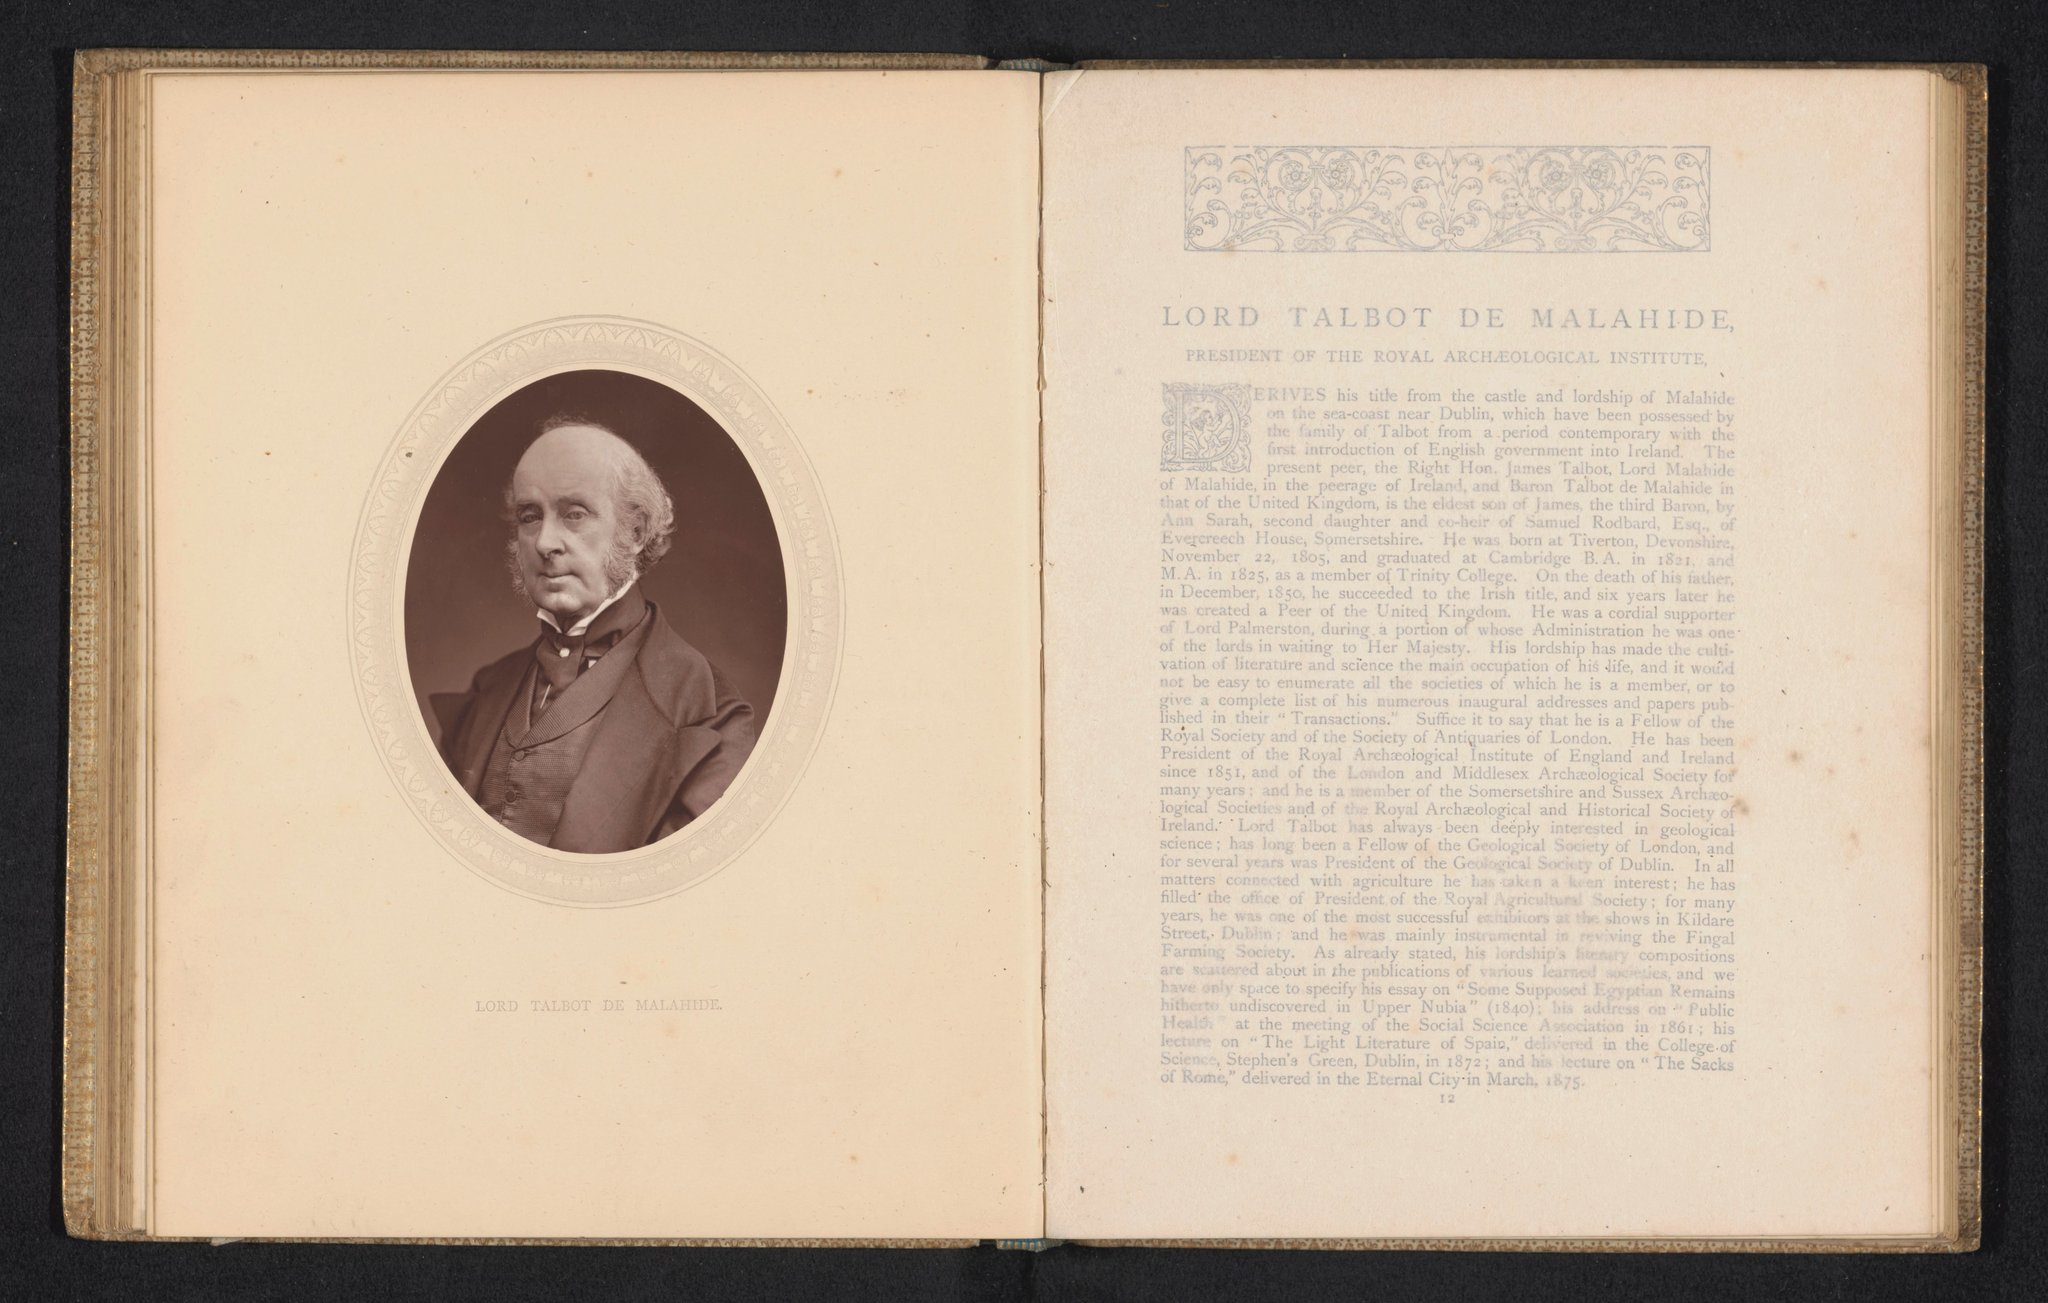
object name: photomechanical print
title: Lord Talbot de Malahide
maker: Anonymous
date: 1871-1876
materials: paper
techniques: woodburytype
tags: politician, historical persons (portraits and scenes from the life) (+ (full) bust portrait), politician, e.g. party leader